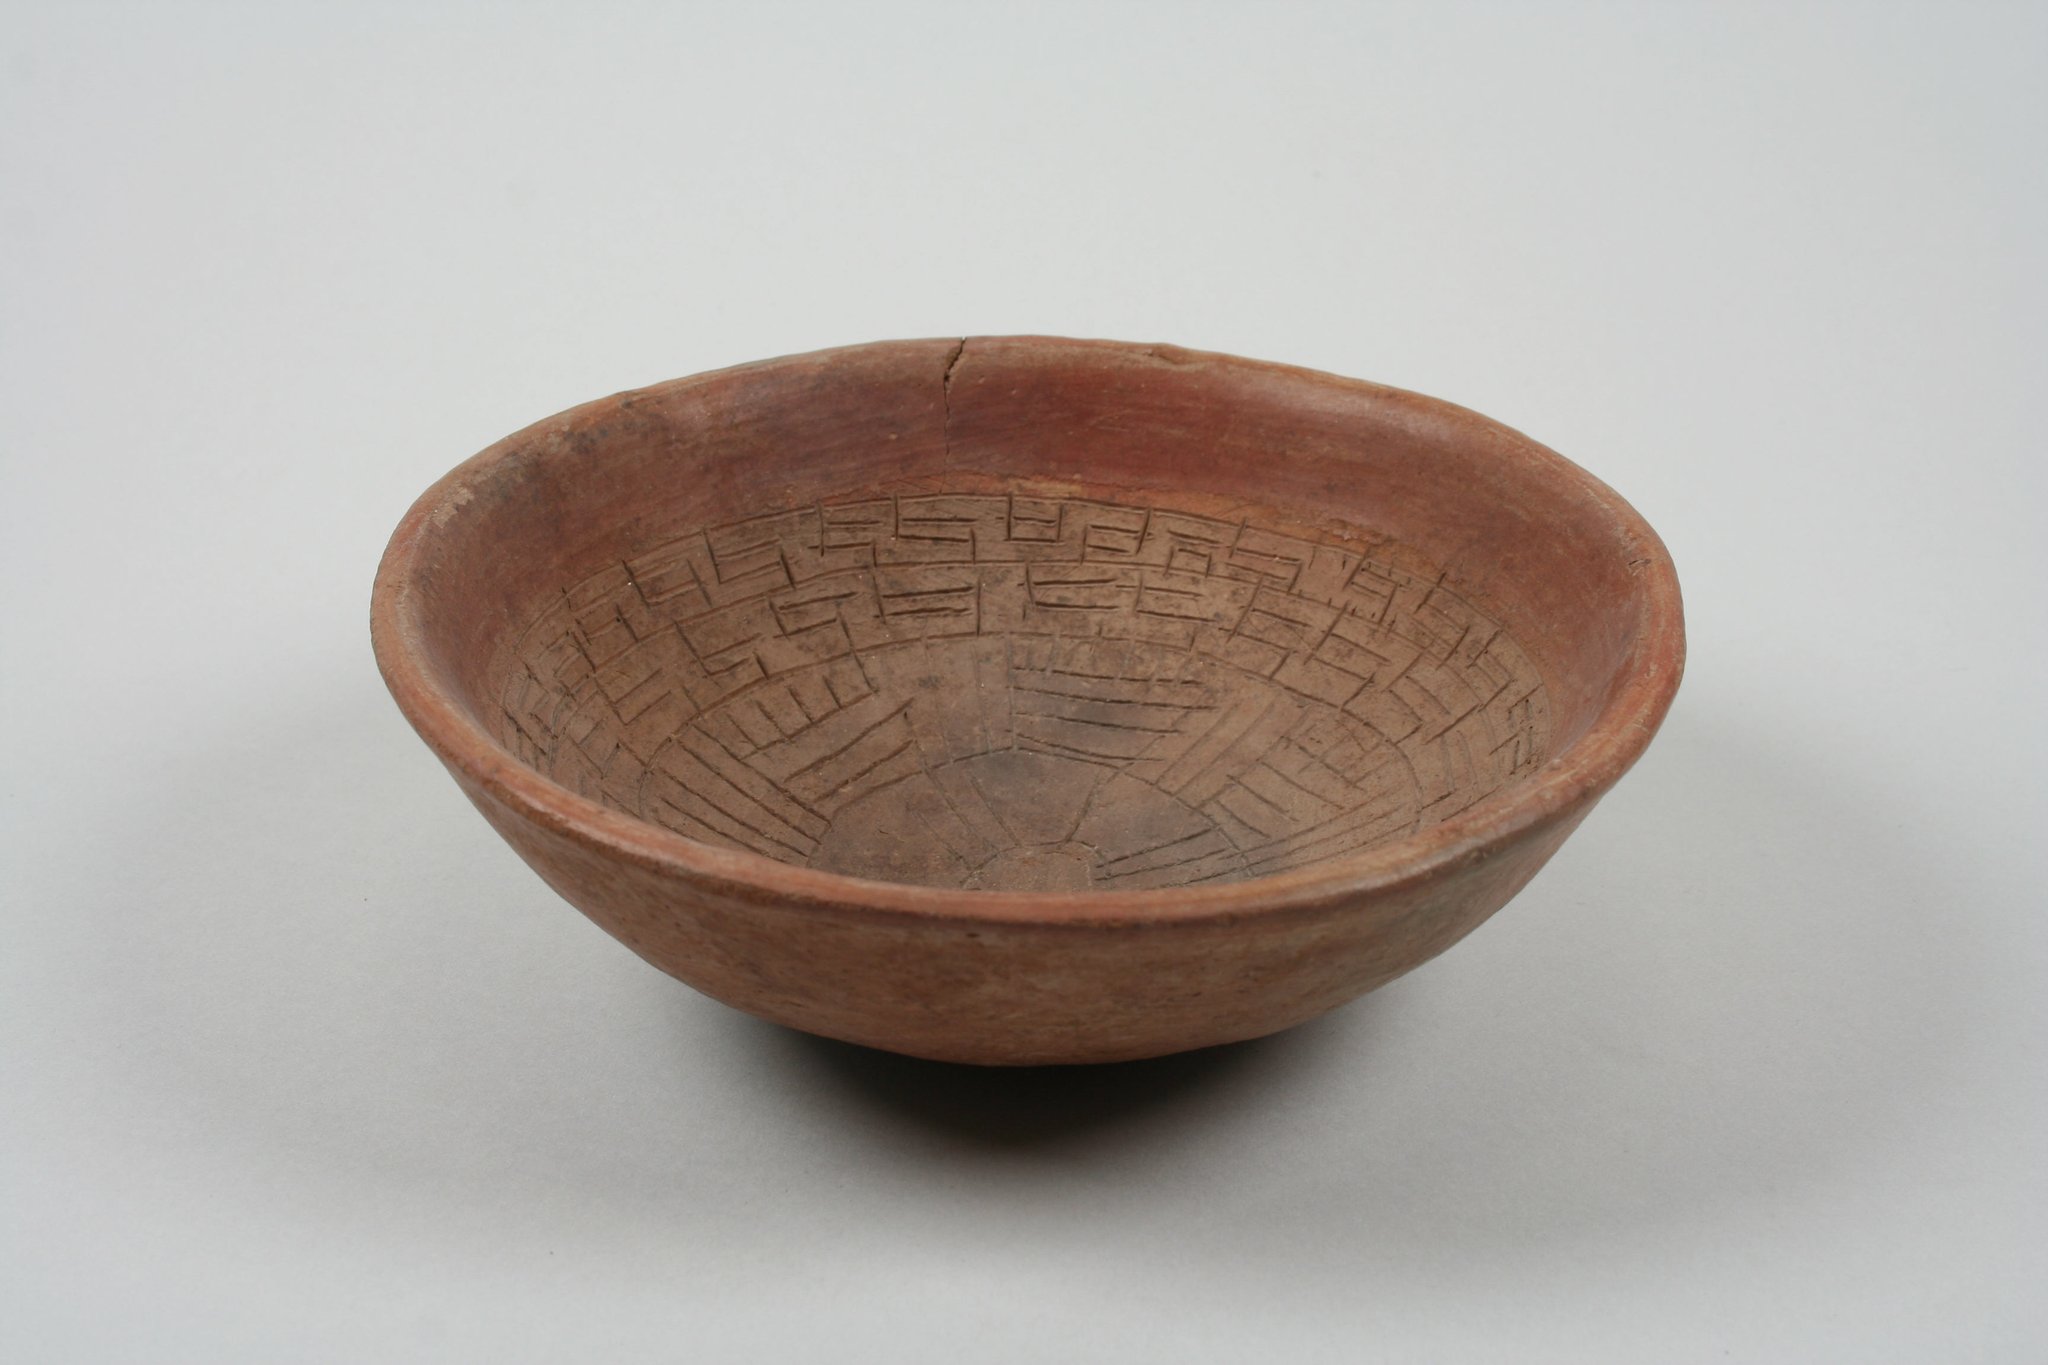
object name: bowl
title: Incised Bowl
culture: paracas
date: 700-301 BCE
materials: ceramic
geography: peru